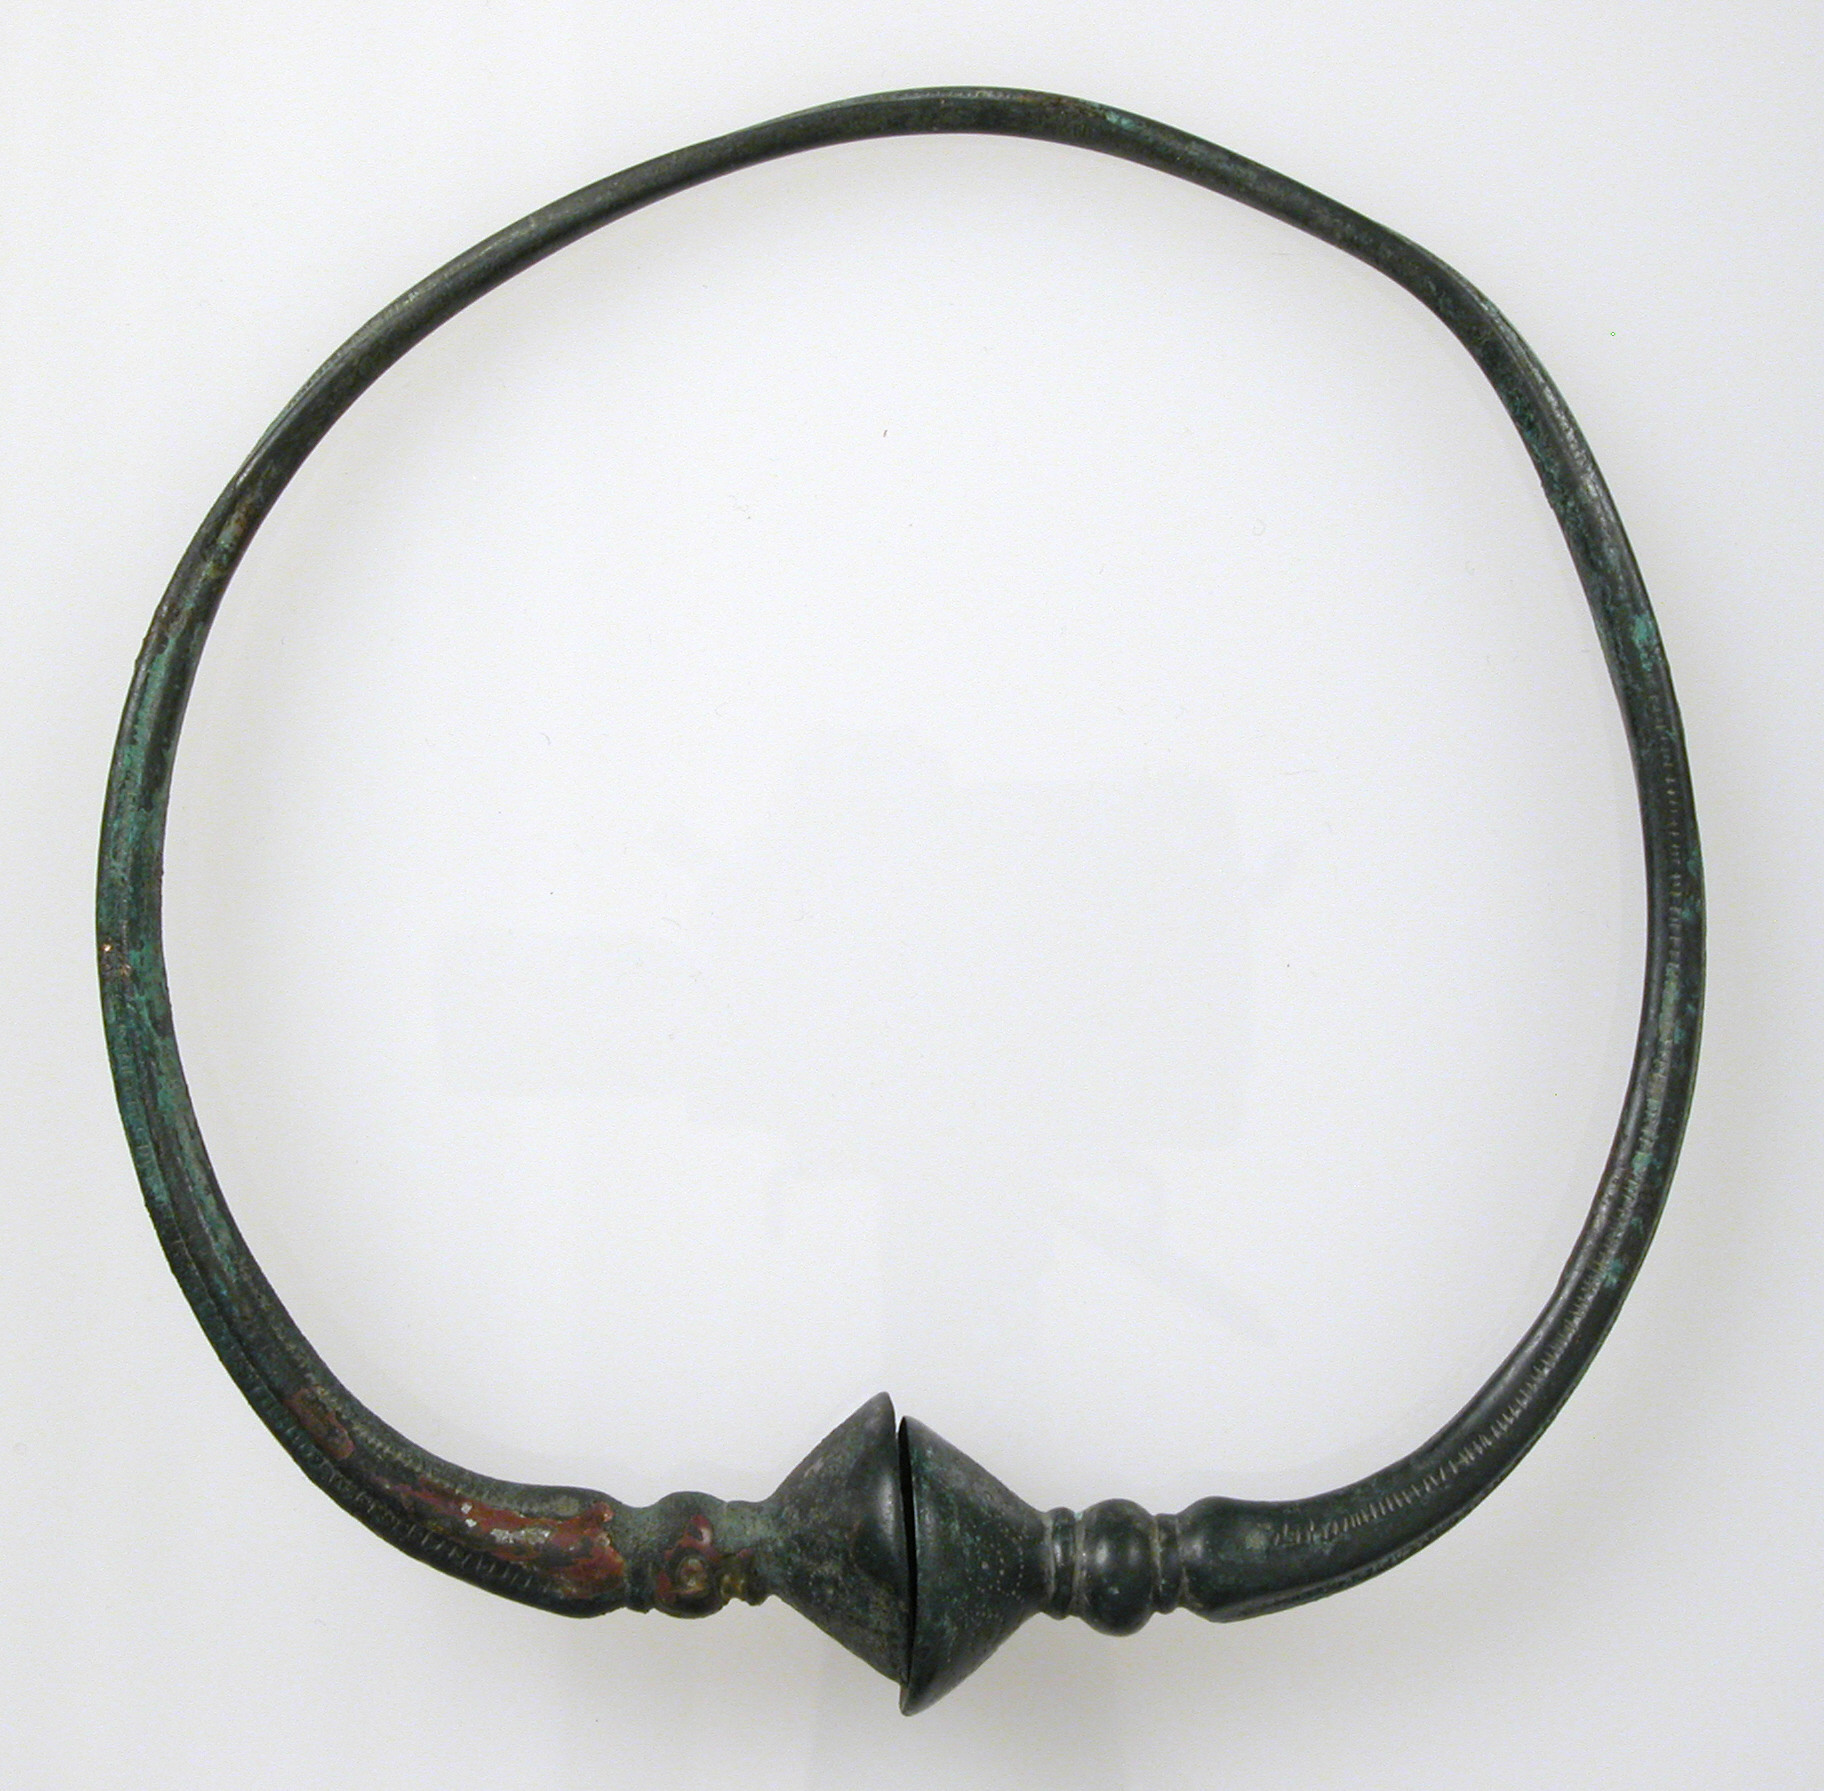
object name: torc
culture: celtic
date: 400-201 BCE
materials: copper alloy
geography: la tène